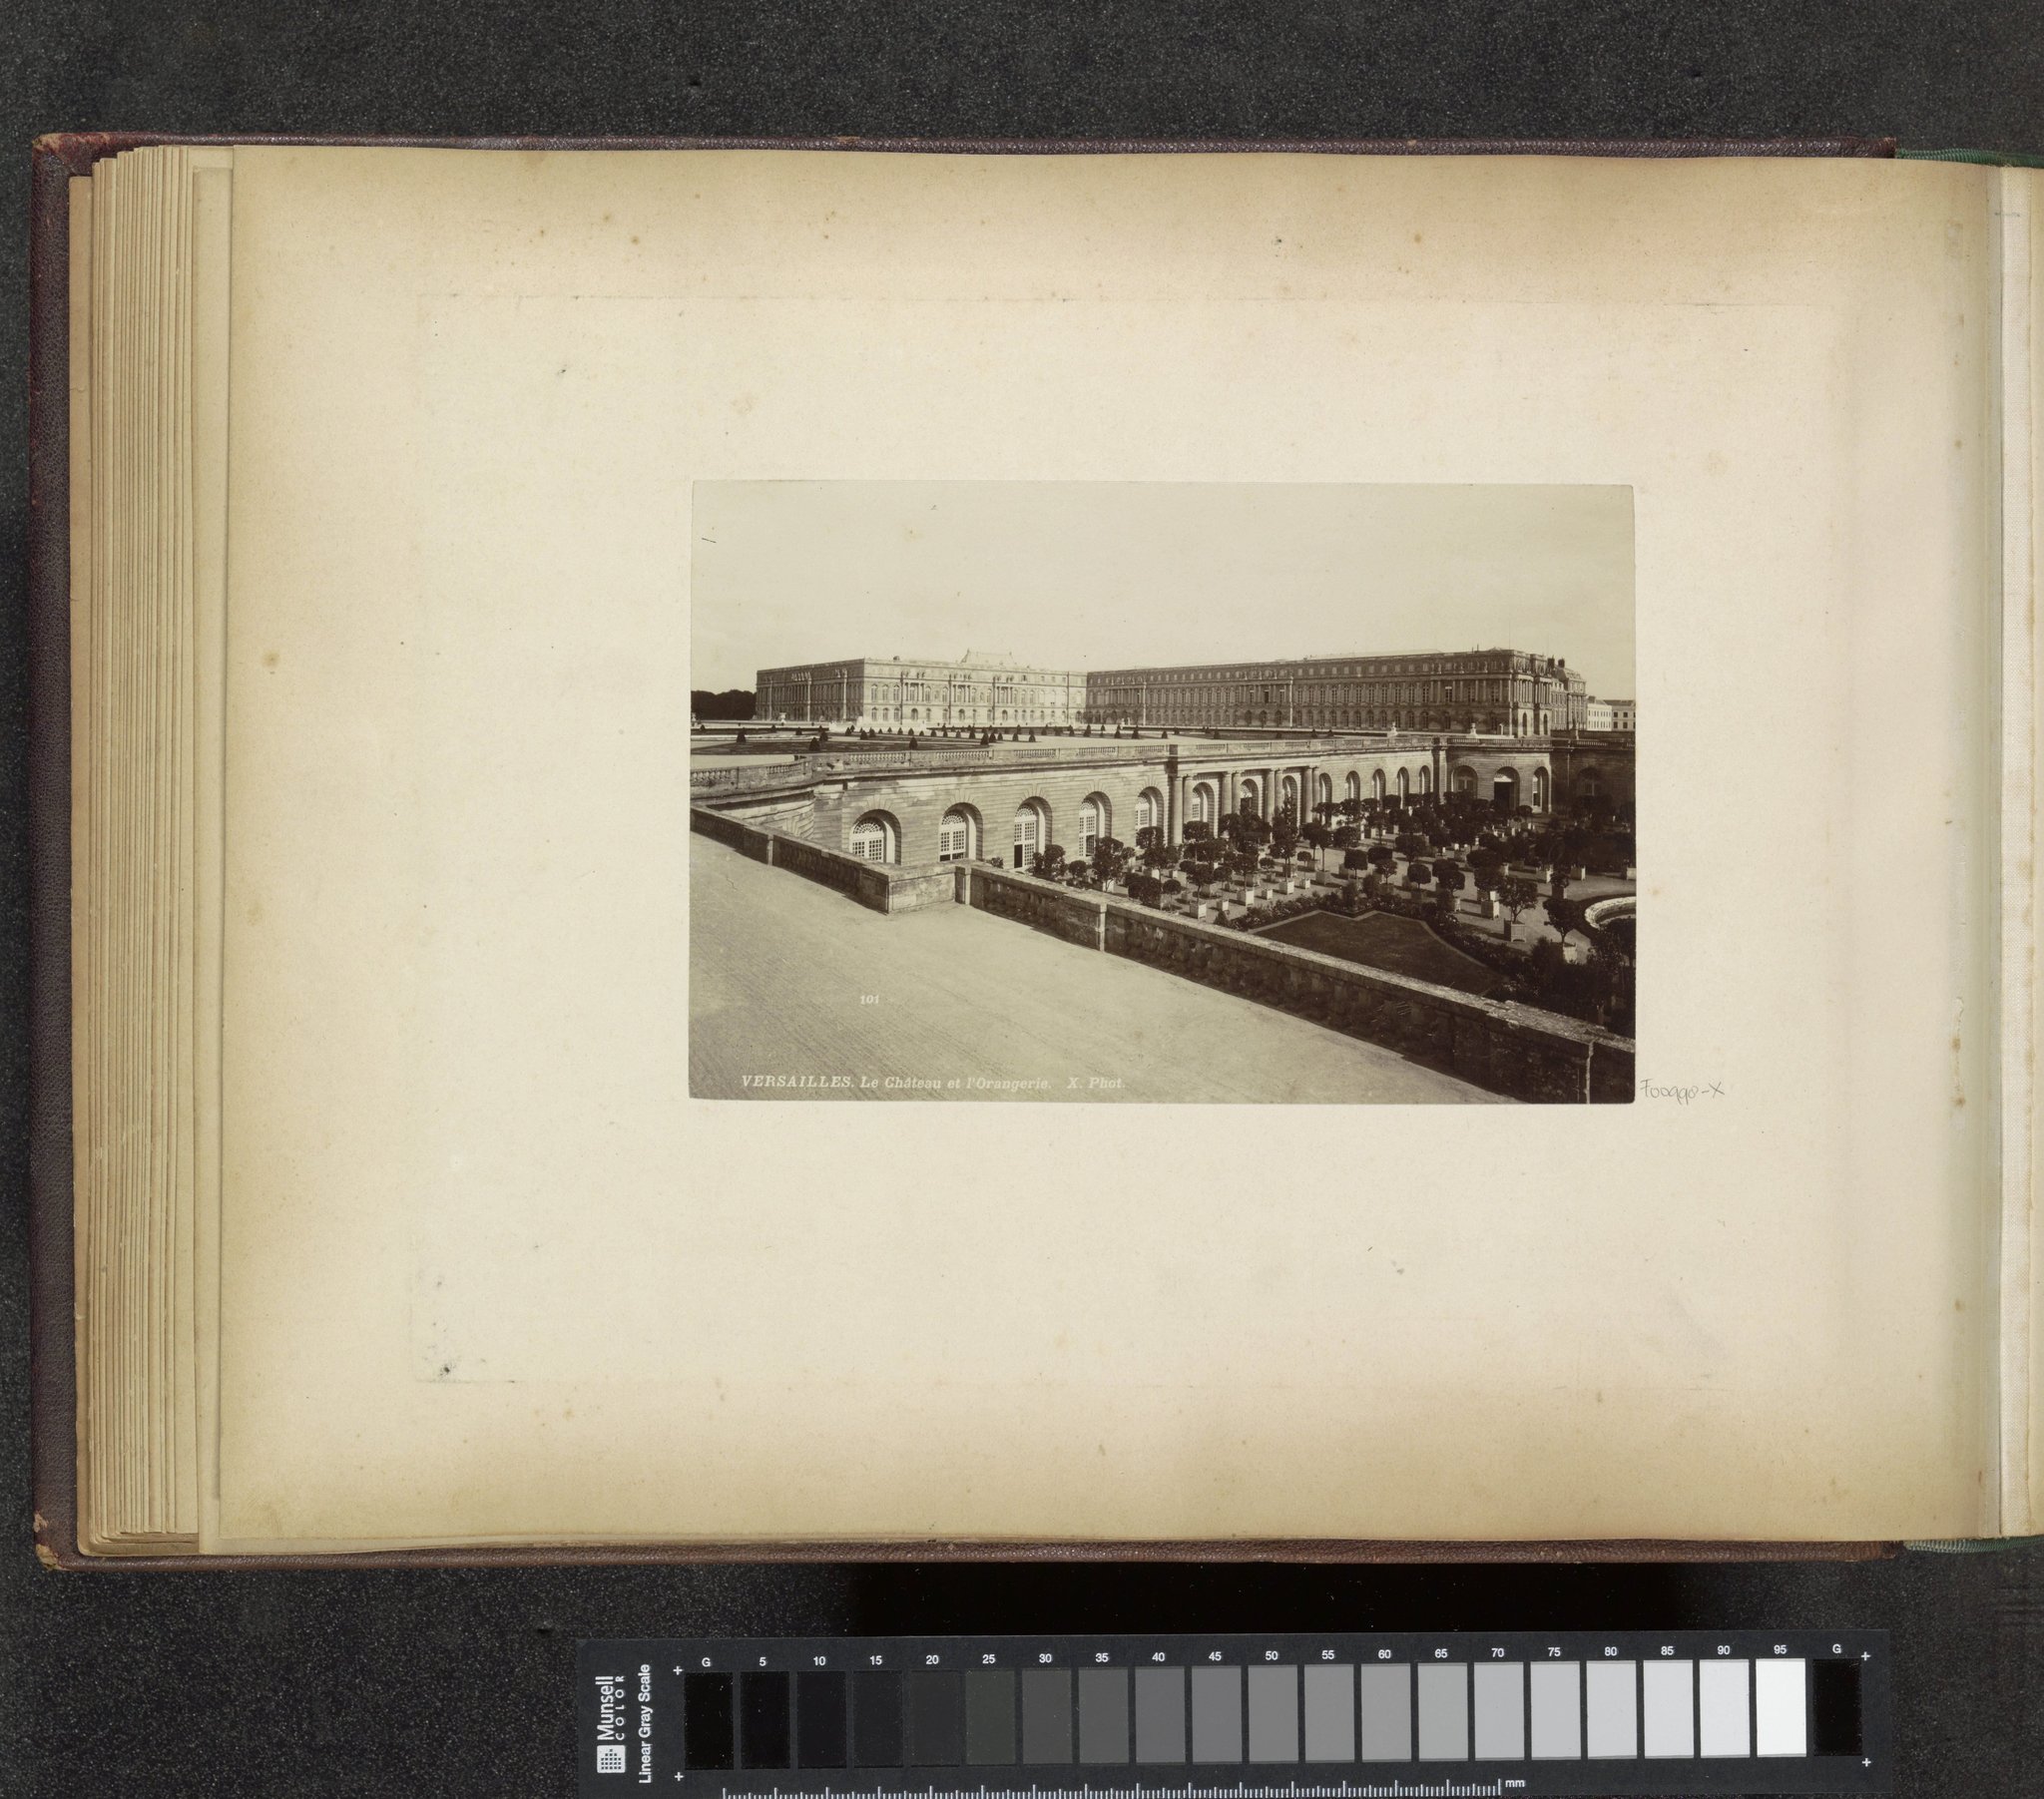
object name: photograph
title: VERSAILLES. Le Château et l'Orangerie.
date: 1880-1895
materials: paper, photographic support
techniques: albumen print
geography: versailles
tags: palace, greenhouse, orangery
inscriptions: negative number: ‘101’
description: Onderdeel van Reisalbum met foto's van bezienswaardigheden in Frankrijk, Griekenland en Turkije.